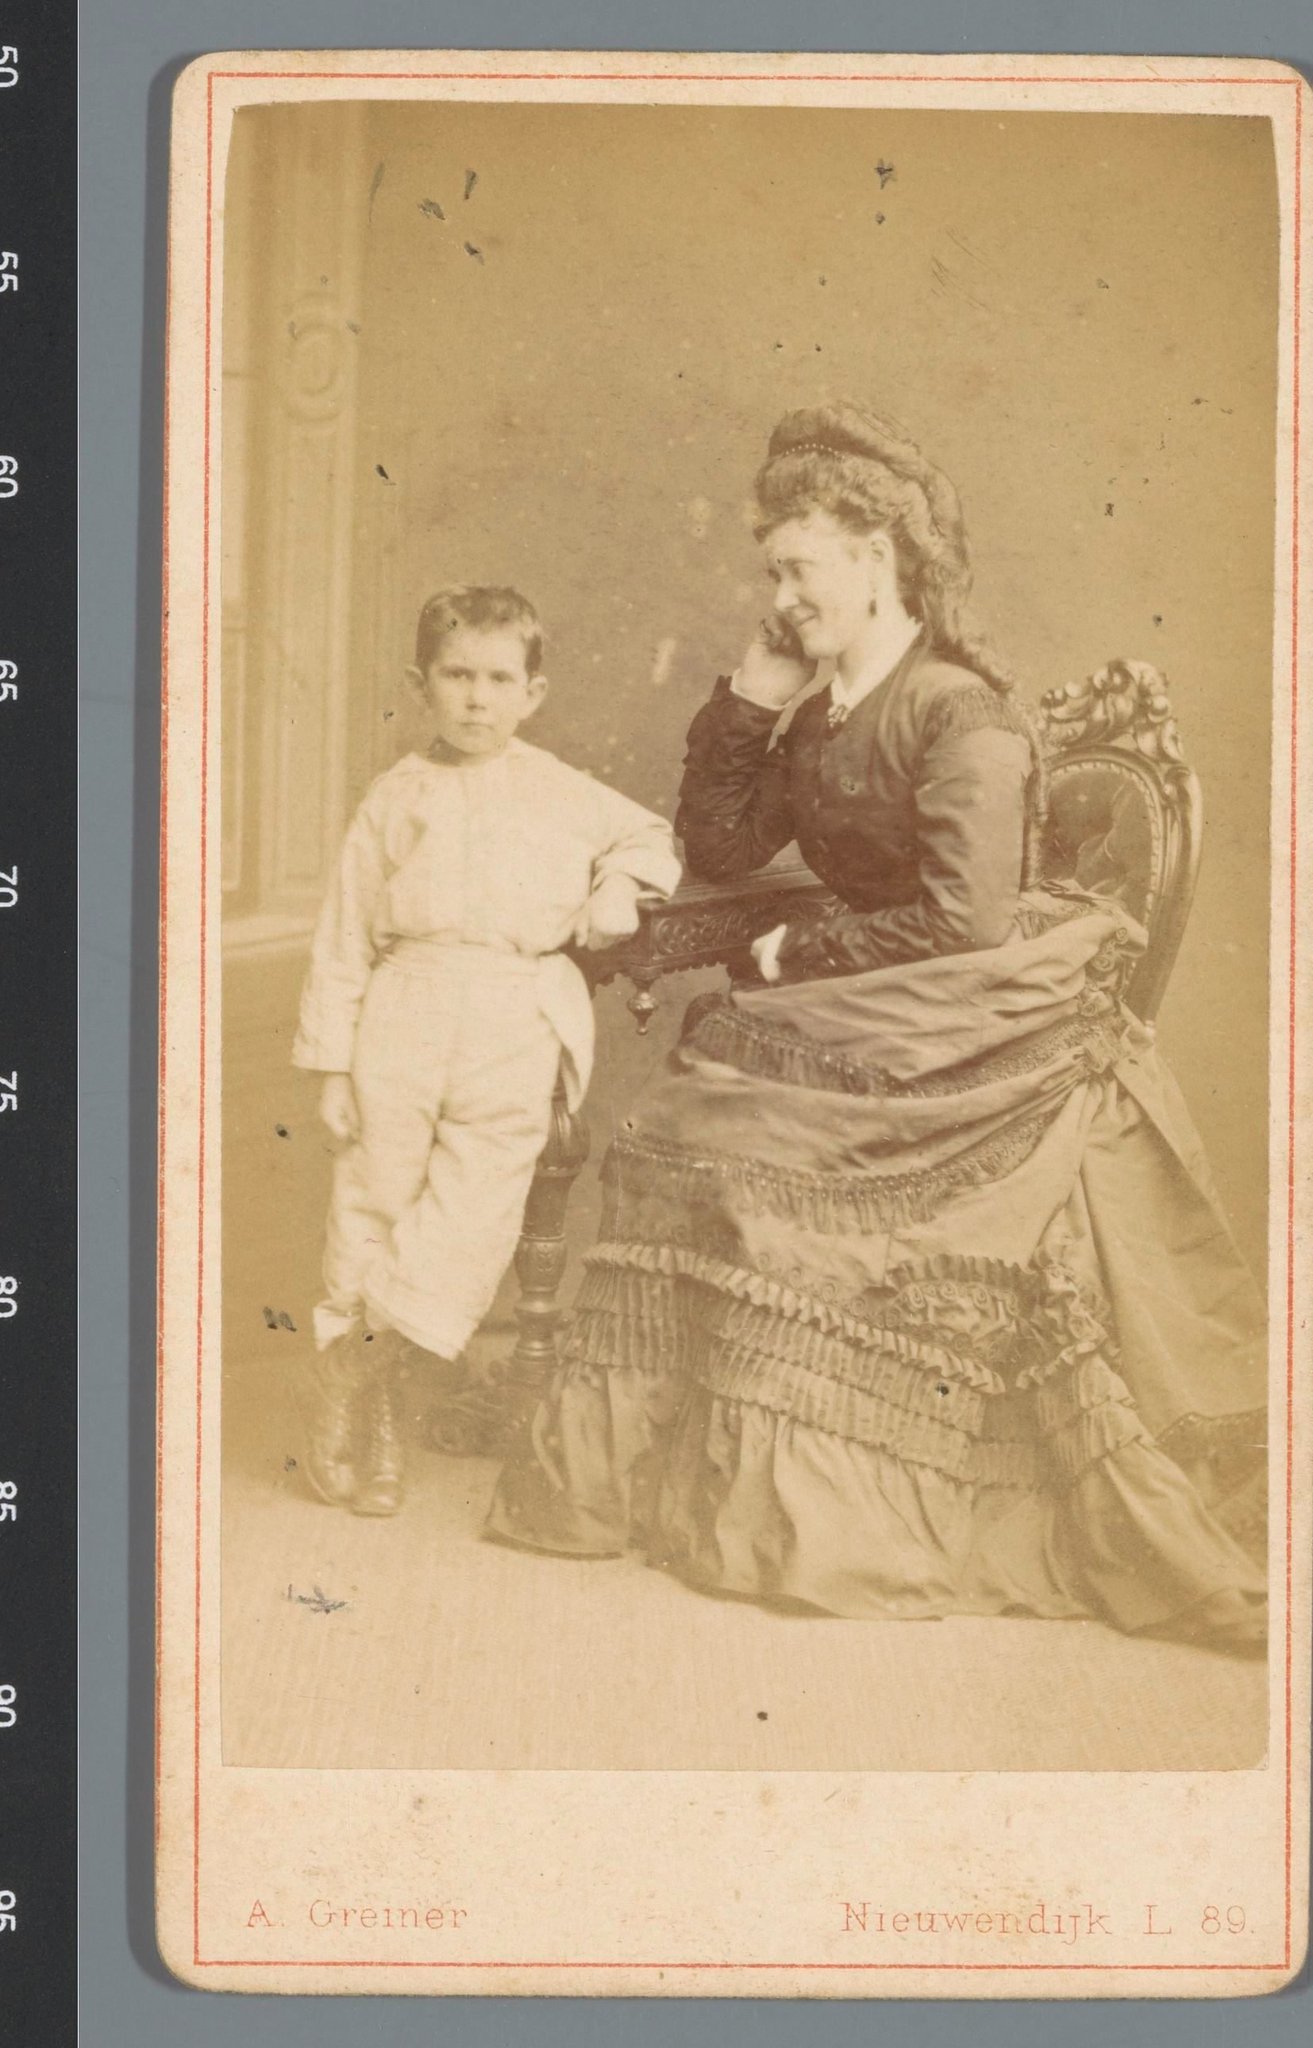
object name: photograph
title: Portret van een onbekende vrouw met een kind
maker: albert greiner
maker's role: fotograaf, fotostudio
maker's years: 1833-1890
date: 1874-1887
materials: cardboard, paper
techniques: albumen print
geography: amsterdam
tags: historical persons, mother and baby or young child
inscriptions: inscription: ‘AG/ A. GREINER/ Photograf/ AMSTERDAM/ NIEUWENDIJK L. 89’